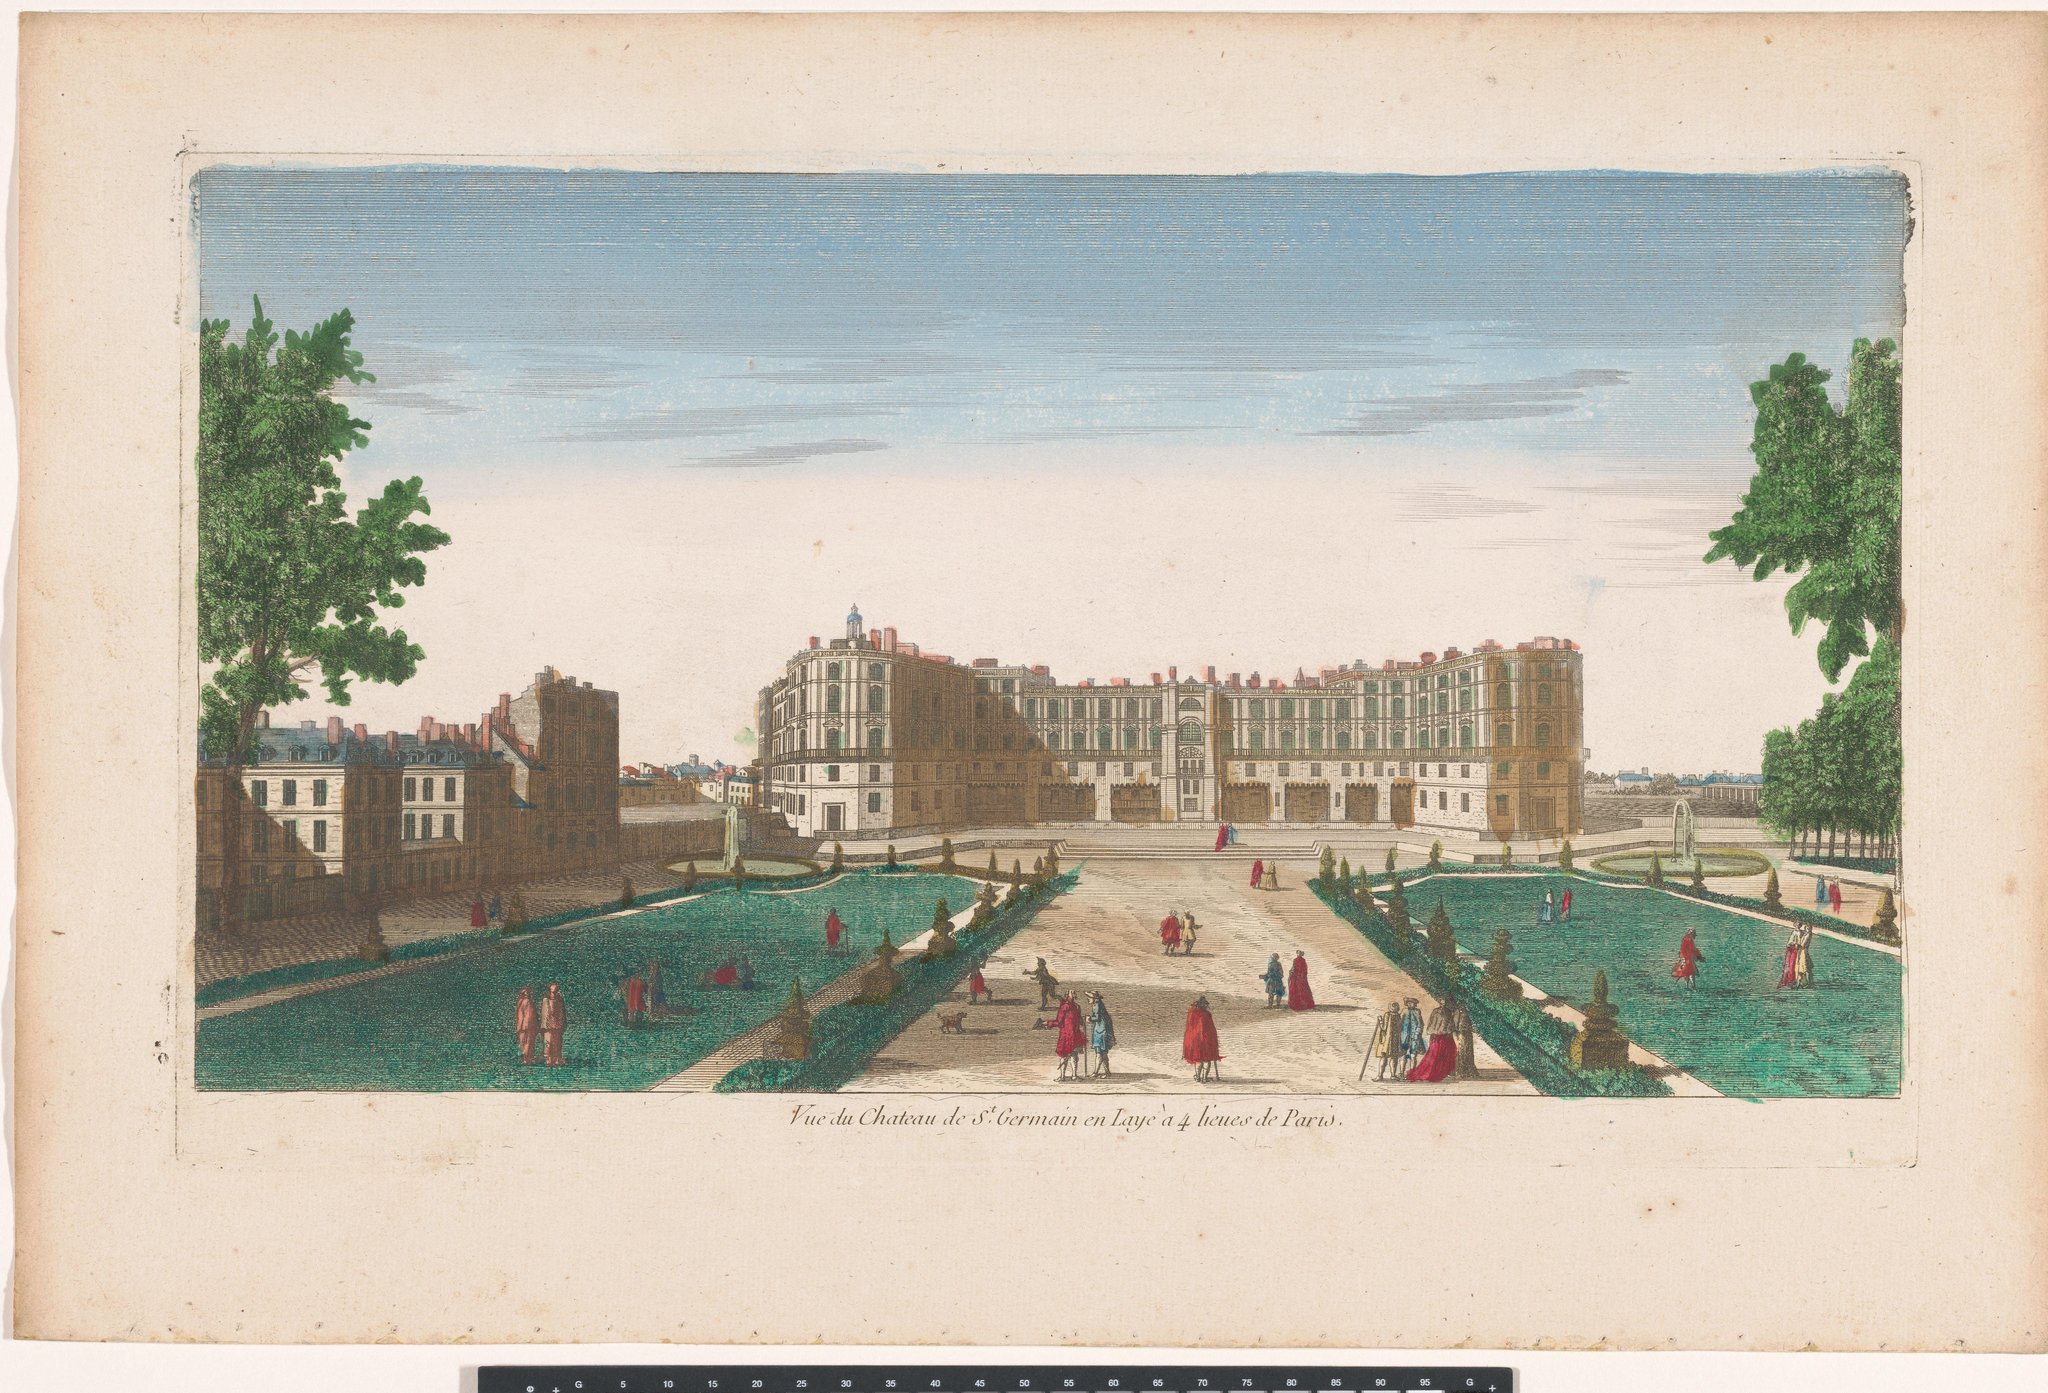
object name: opticaprent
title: Gezicht op het Château de Saint-Germain-en-Laye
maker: Anonymous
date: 1700-1799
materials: paper, watercolor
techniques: brush, etching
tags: civic architecture; edifices; dwellings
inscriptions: collector's mark: Lugt 2166, watermark